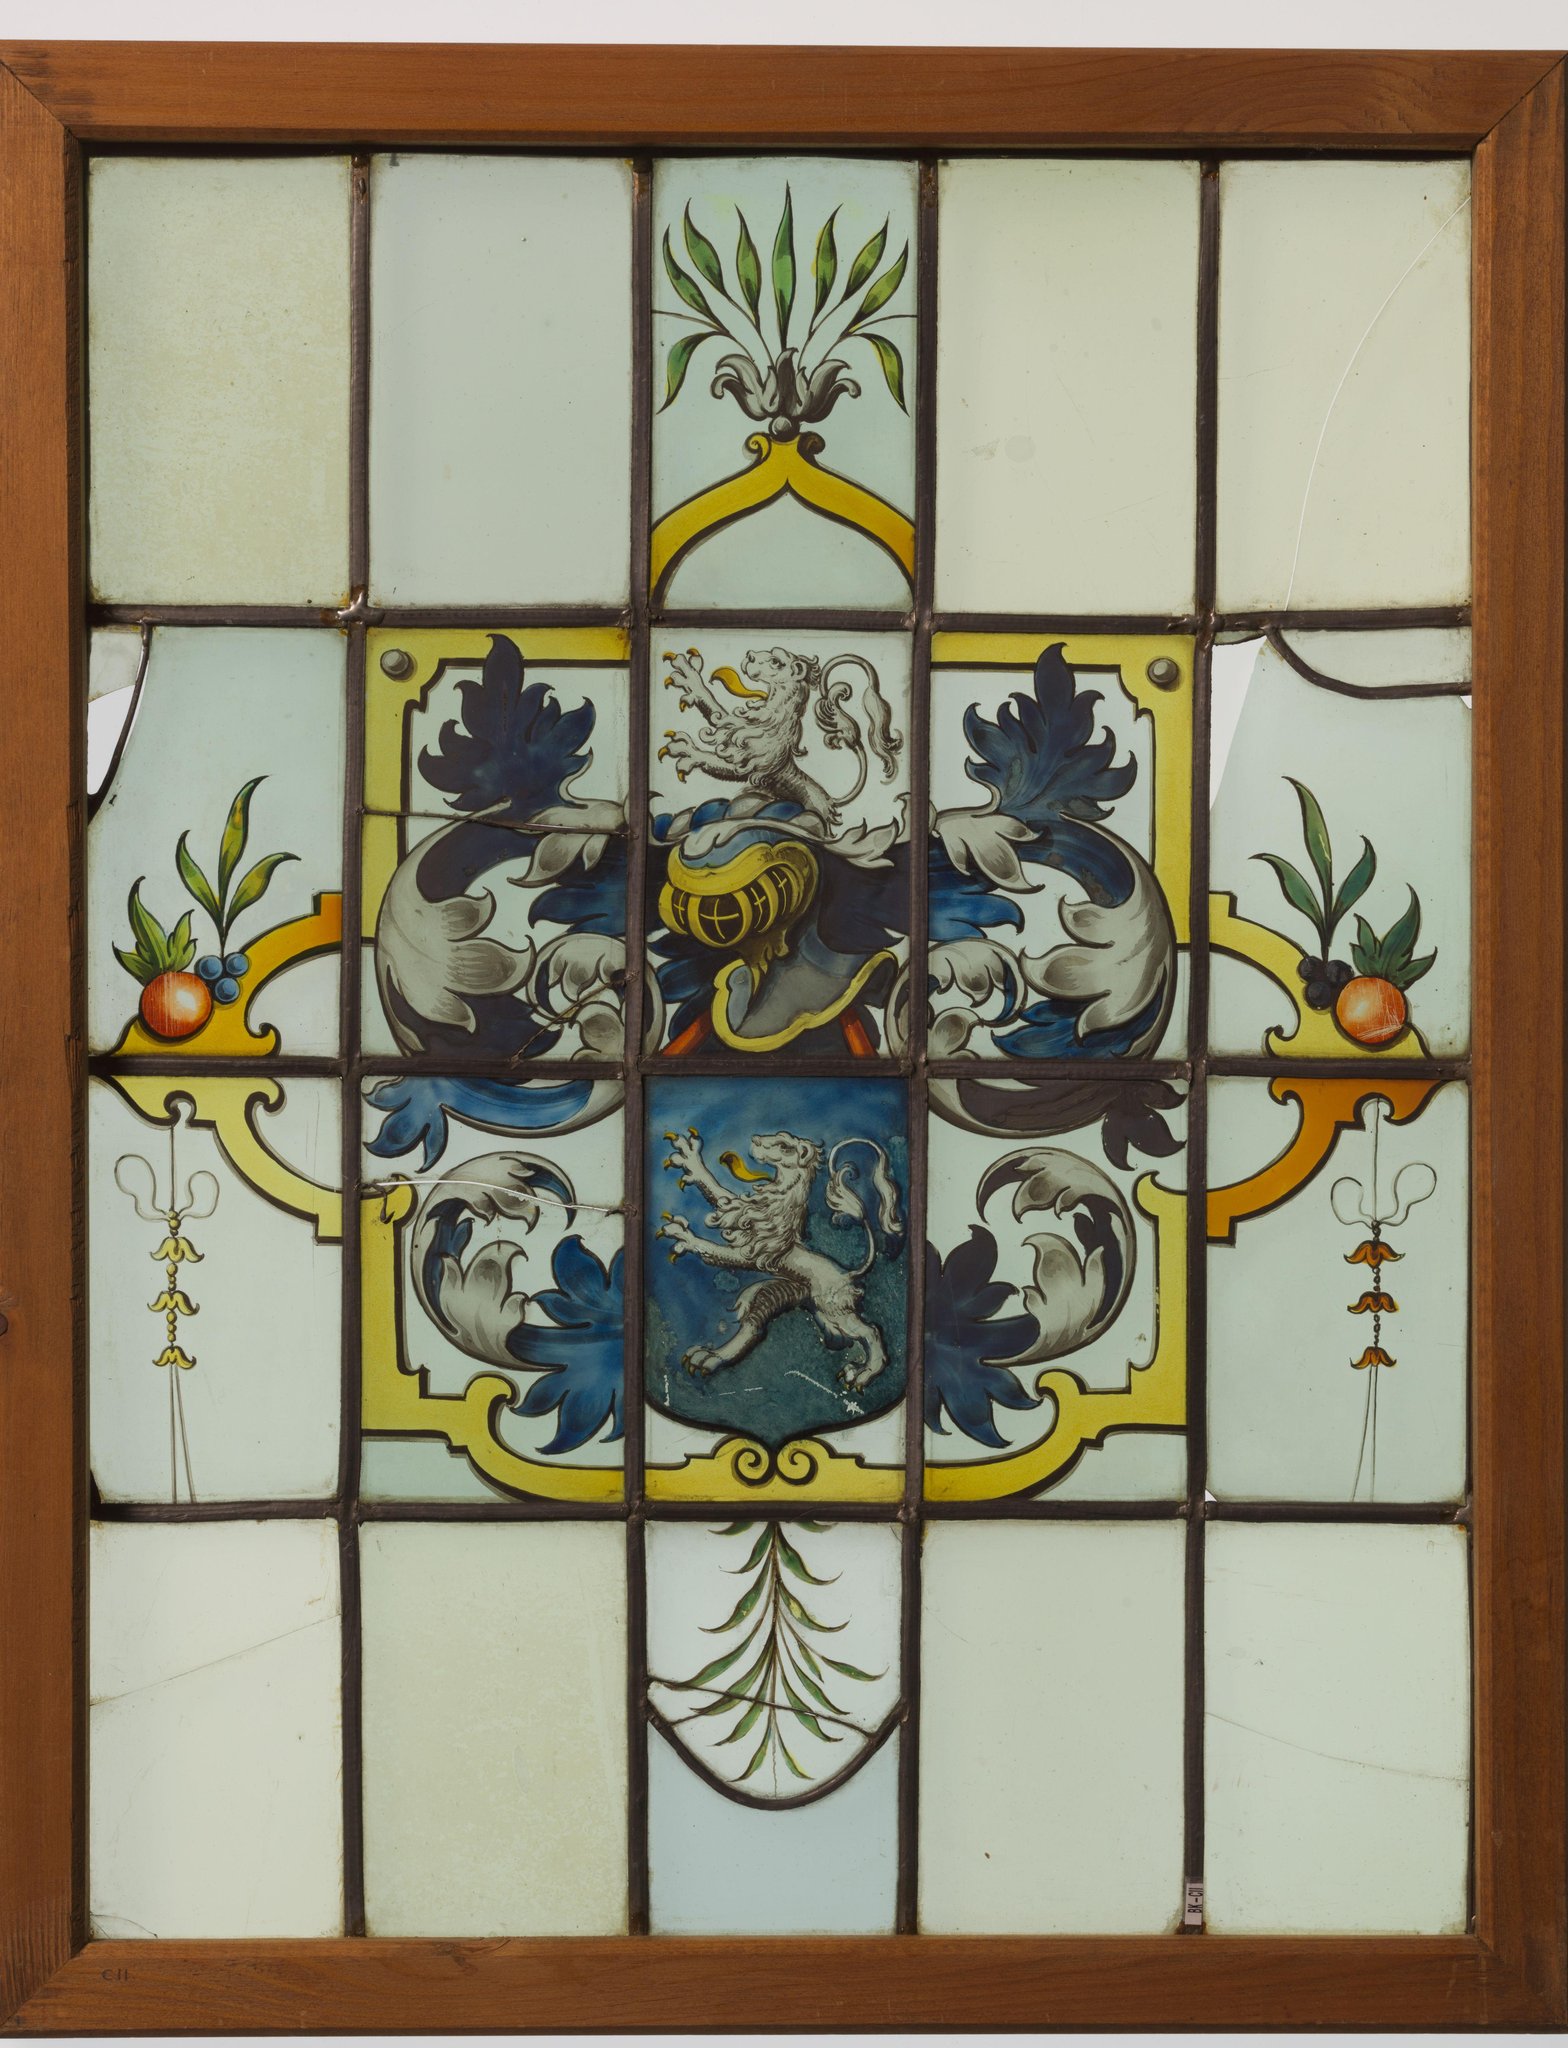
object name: light window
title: Ruit met zilveren leeuw en als helmteken eveneens een zilveren leeuw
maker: Anonymous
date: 1650-1700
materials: glass, lead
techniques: leading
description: Wapenruit met als wapenschild een zilveren leeuw op een blauw veld en als helmteken eveneens een zilveren leeuw. Omlijsting met vruchten. Vermoedelijk het familiewapen van Van Meerten uit Arkel)